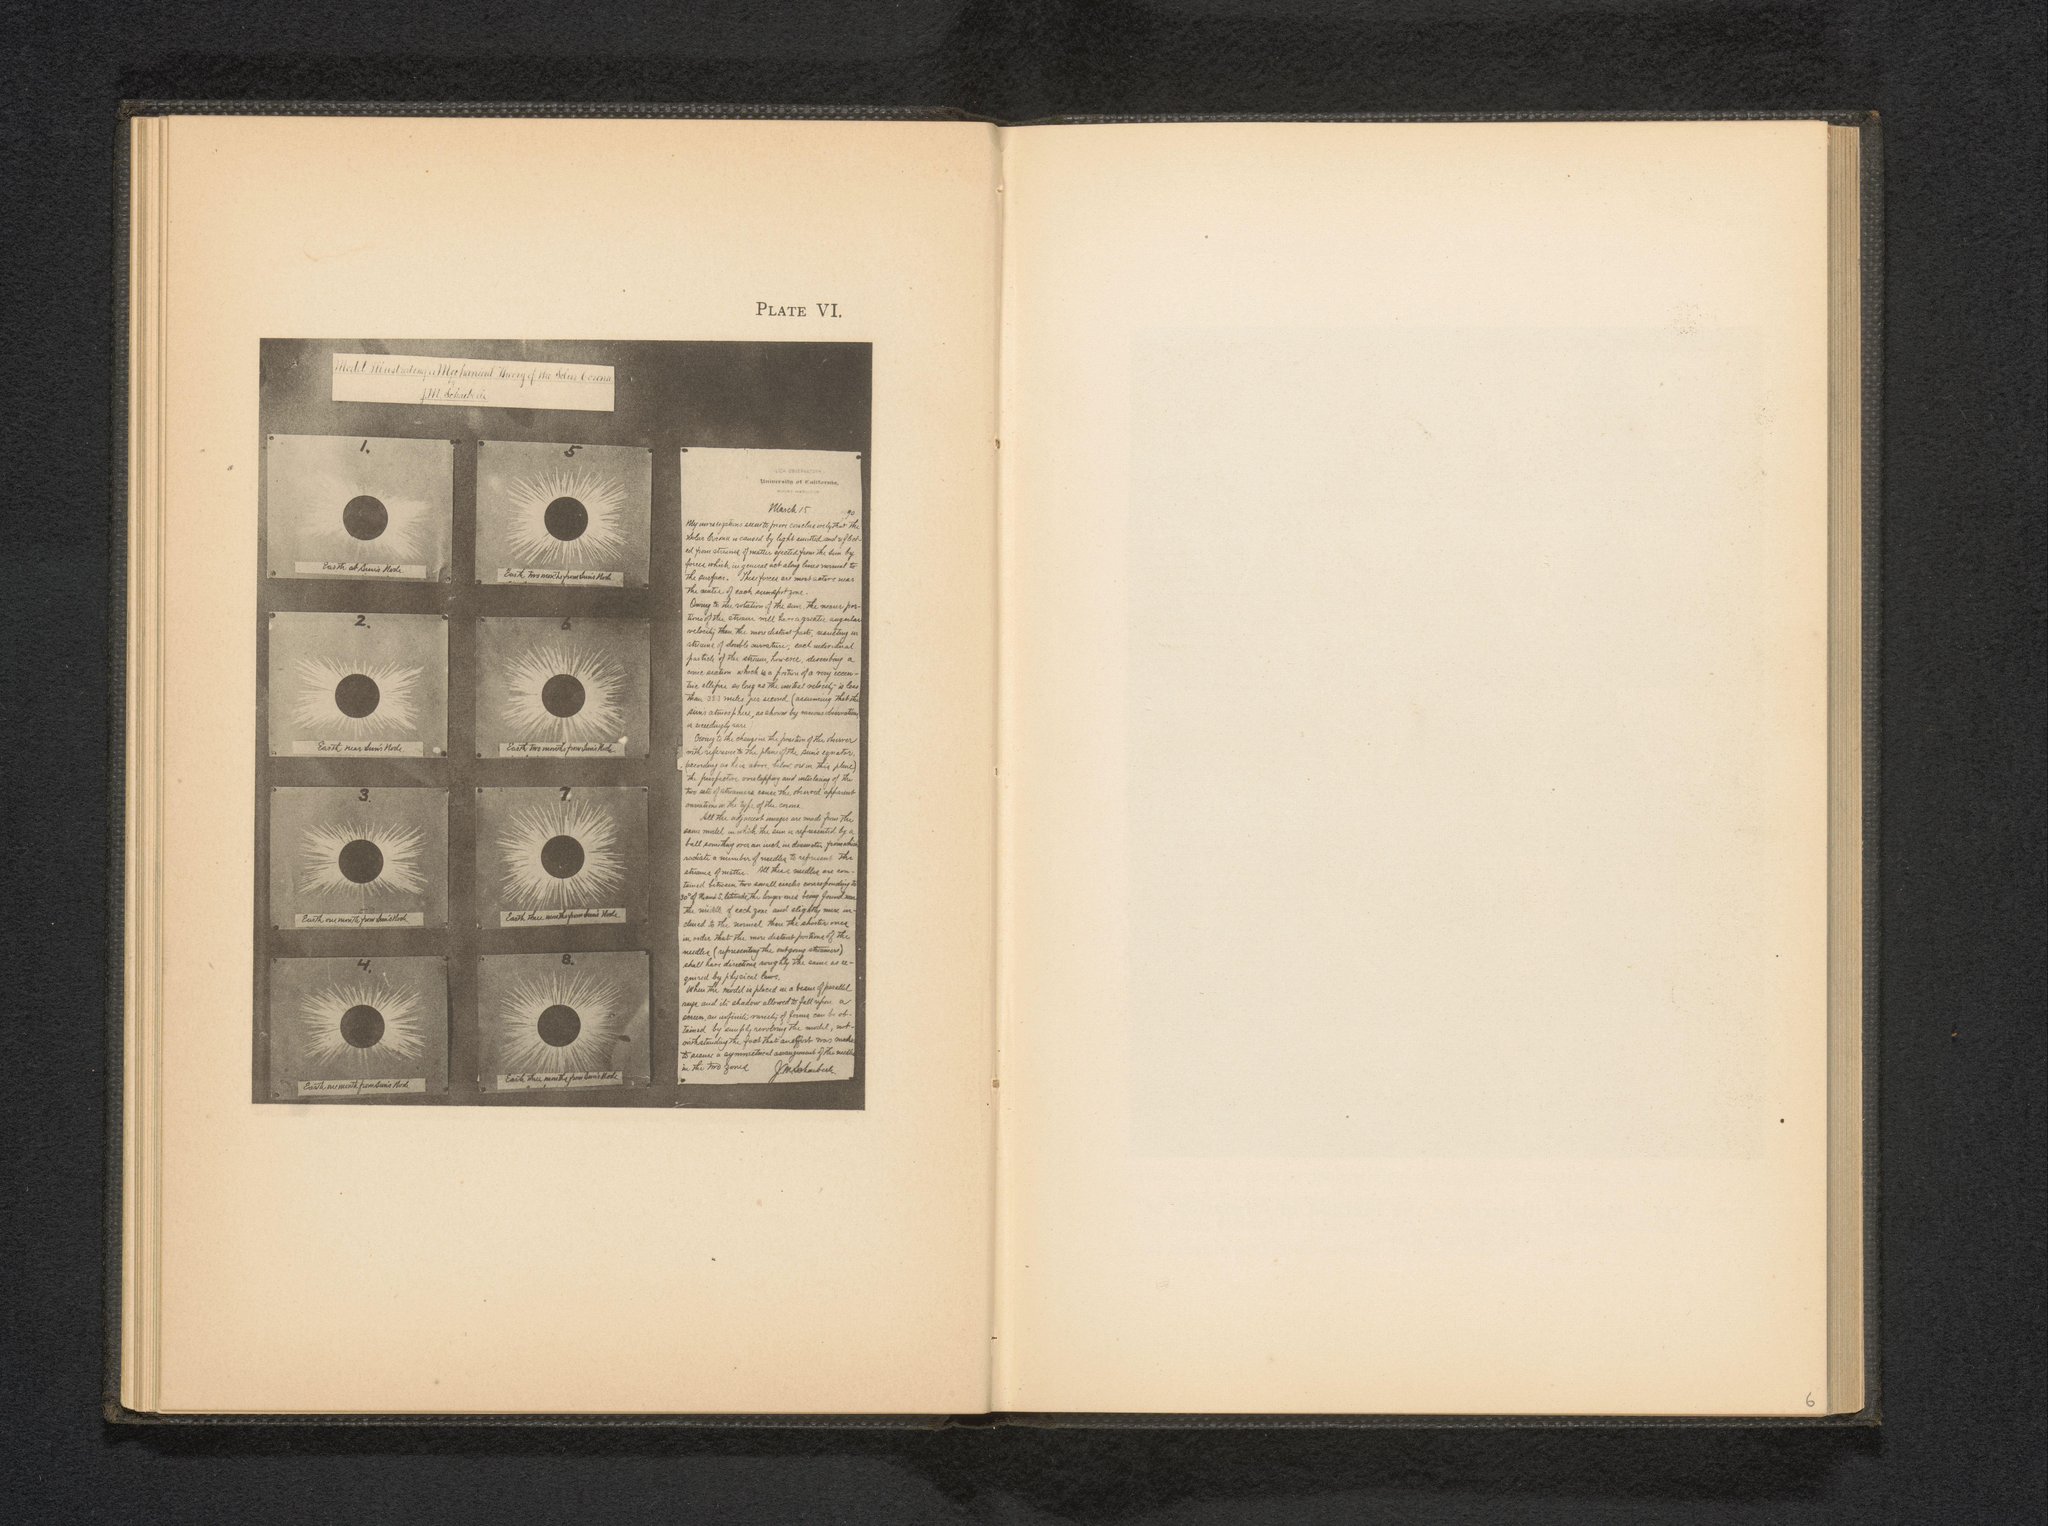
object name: photomechanical print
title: Acht afbeeldingen van een zonsverduistering en een handgeschreven brief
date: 1886-1891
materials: paper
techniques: photograph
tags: total solar eclipse with corona, letter, envelope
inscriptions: inscription: ‘Plate VI.’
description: Prent op tweede ongenummerde pagina na pagina 46.